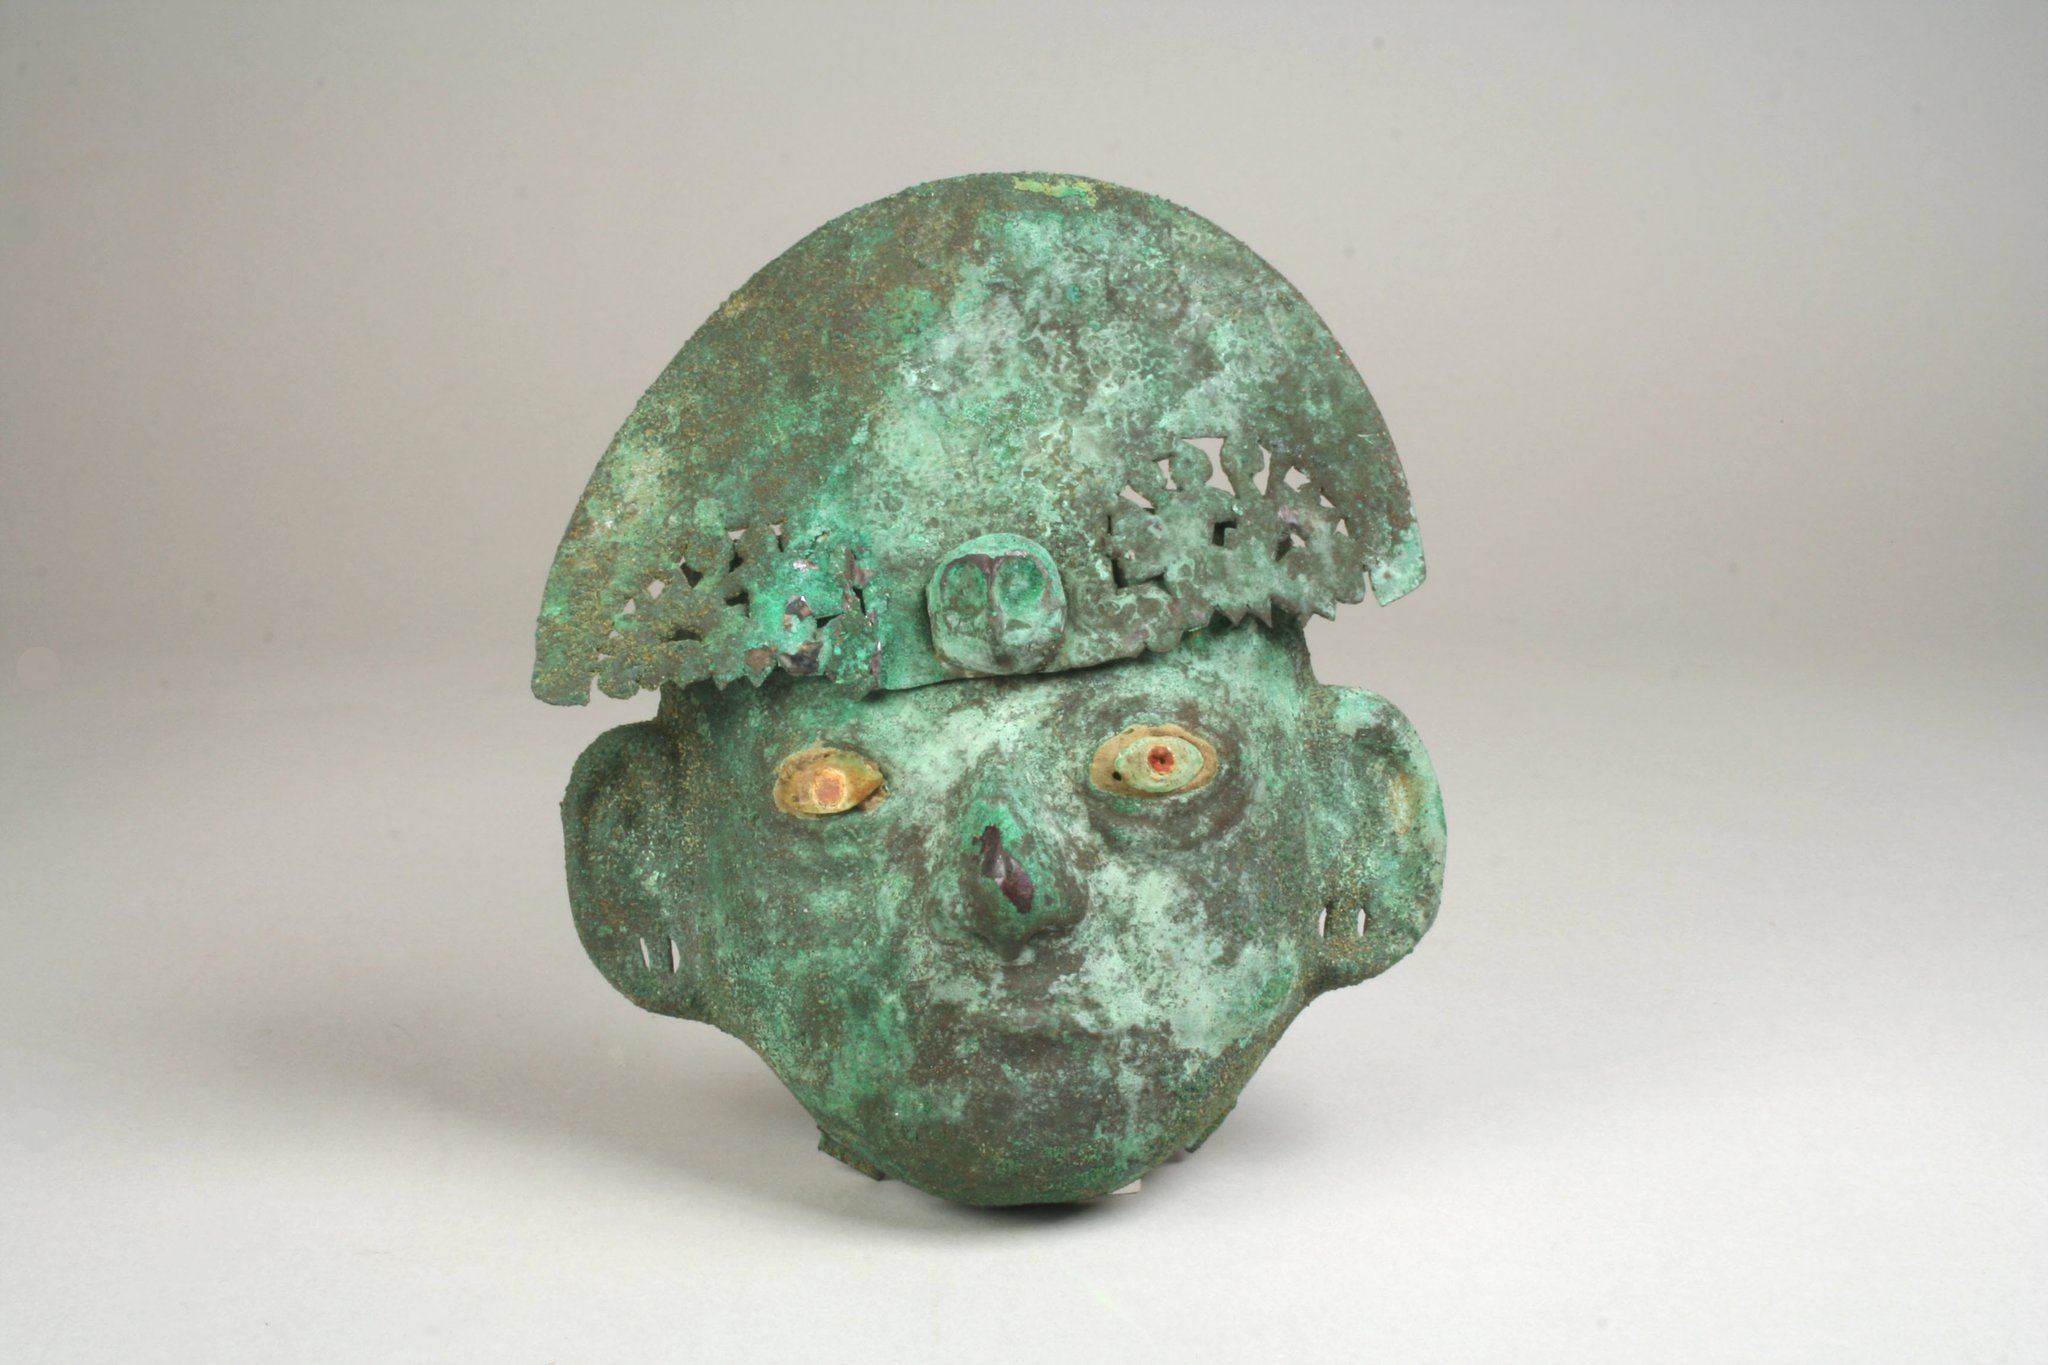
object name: ornament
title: Mask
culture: moche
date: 501-700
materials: metal, stone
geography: peru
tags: masks